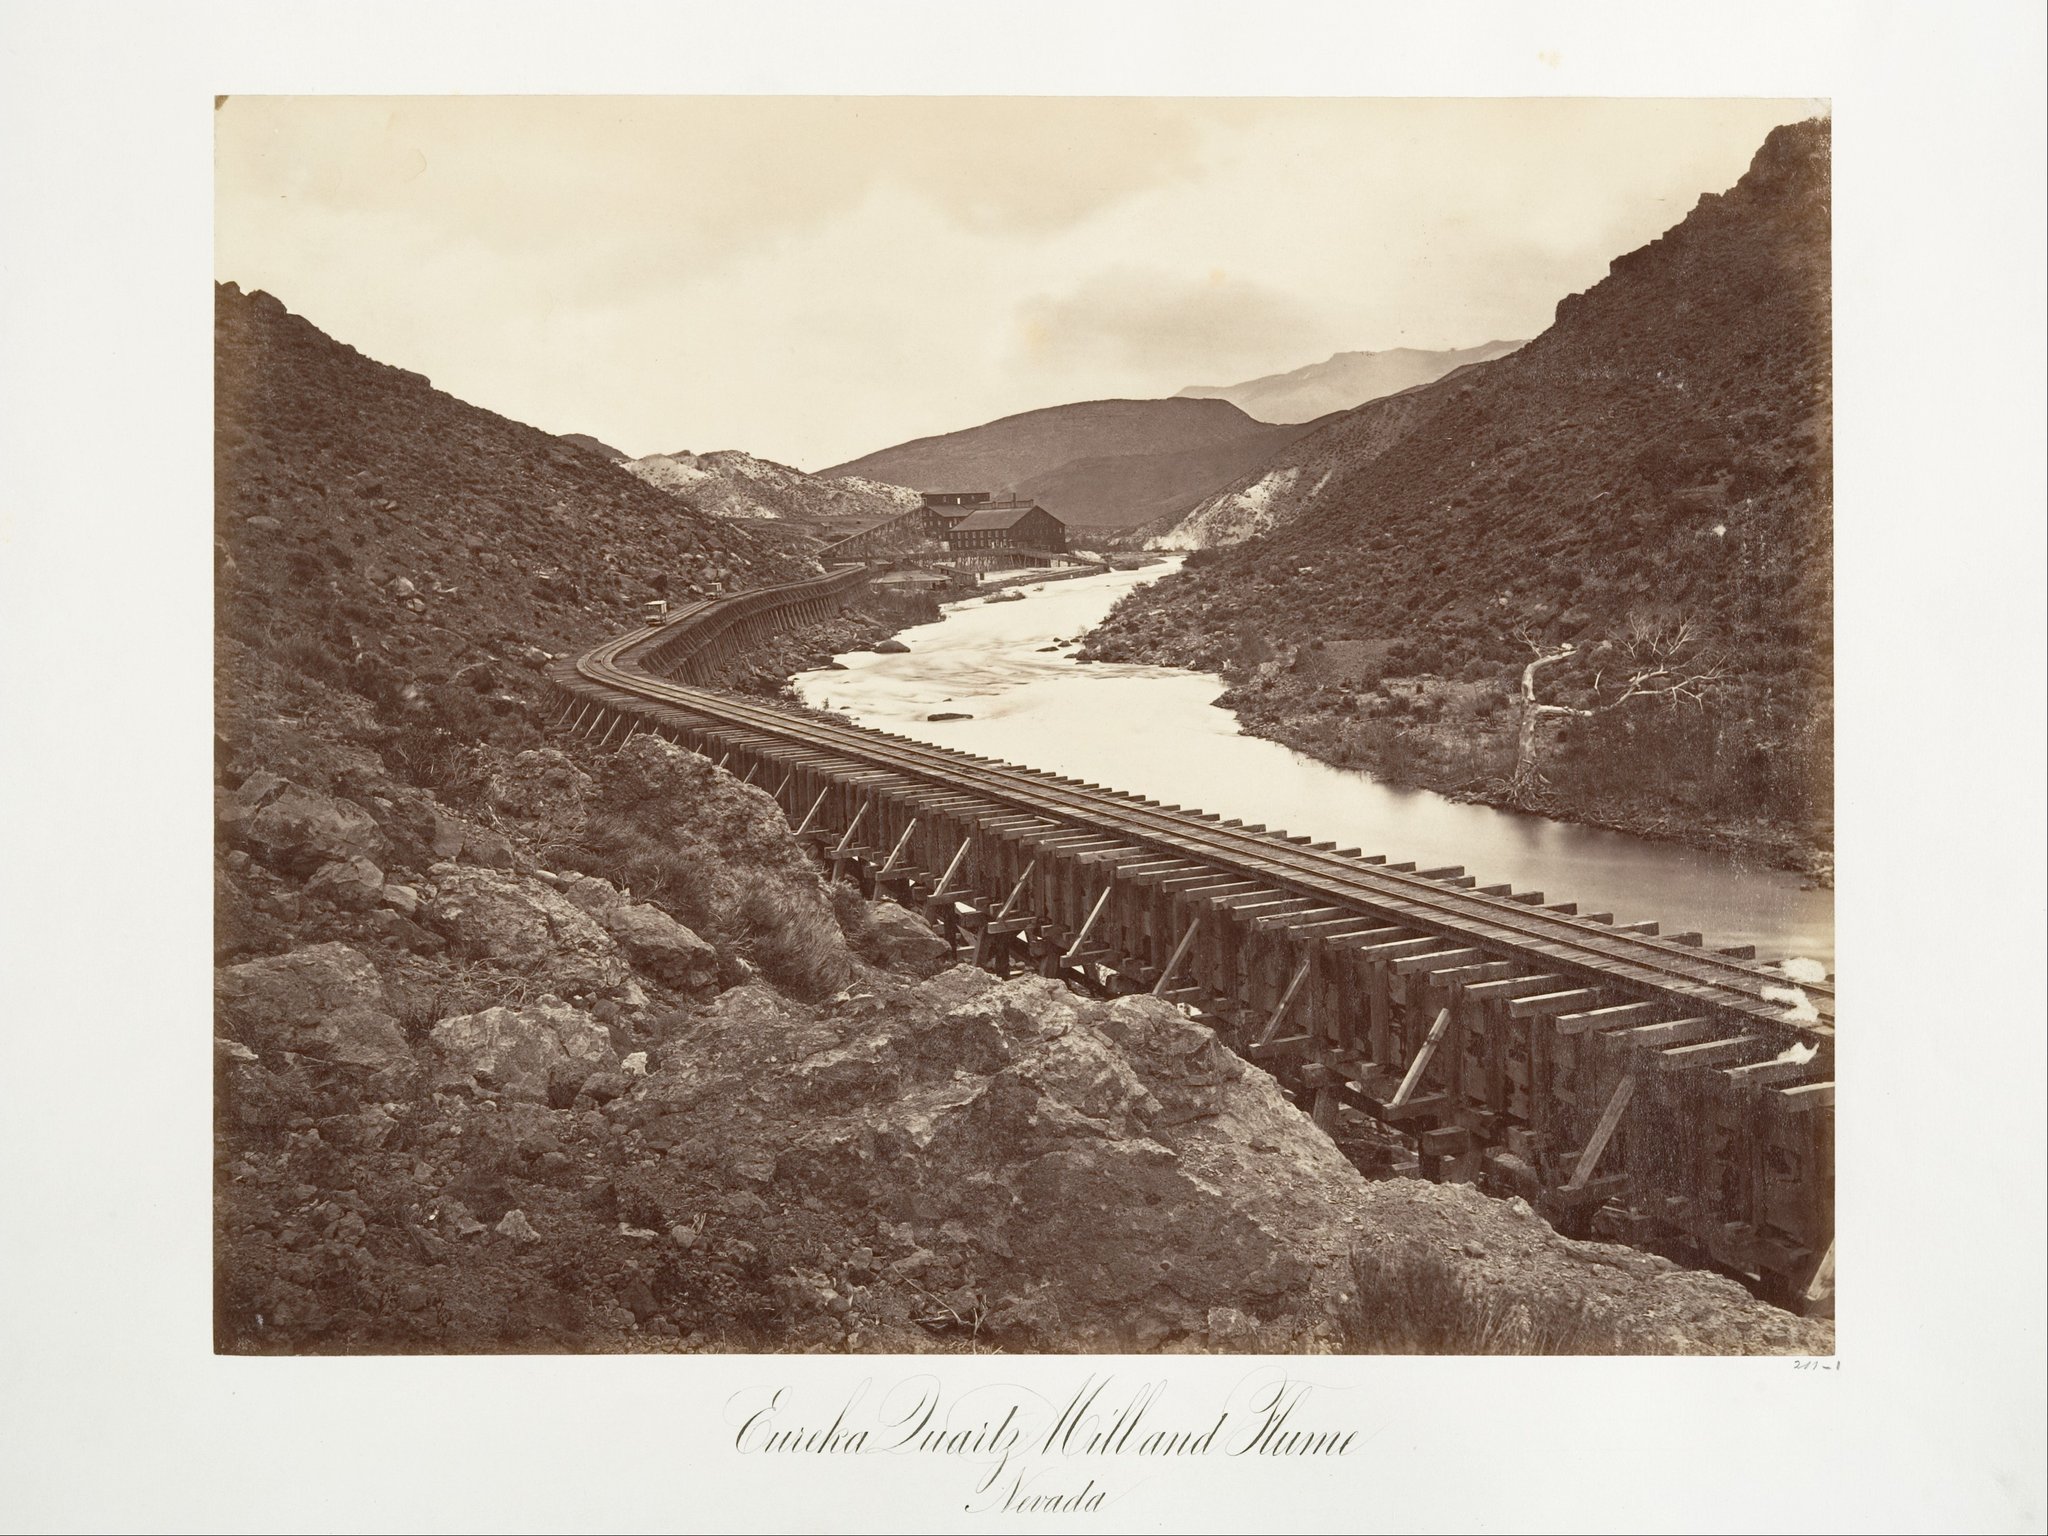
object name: photograph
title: Eureka Quartz Mill and Flume, Nevada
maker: carleton e. watkins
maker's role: artist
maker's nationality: american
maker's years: 1829-1916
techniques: albumen silver print, glass negative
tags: railways,mountains,landscapes